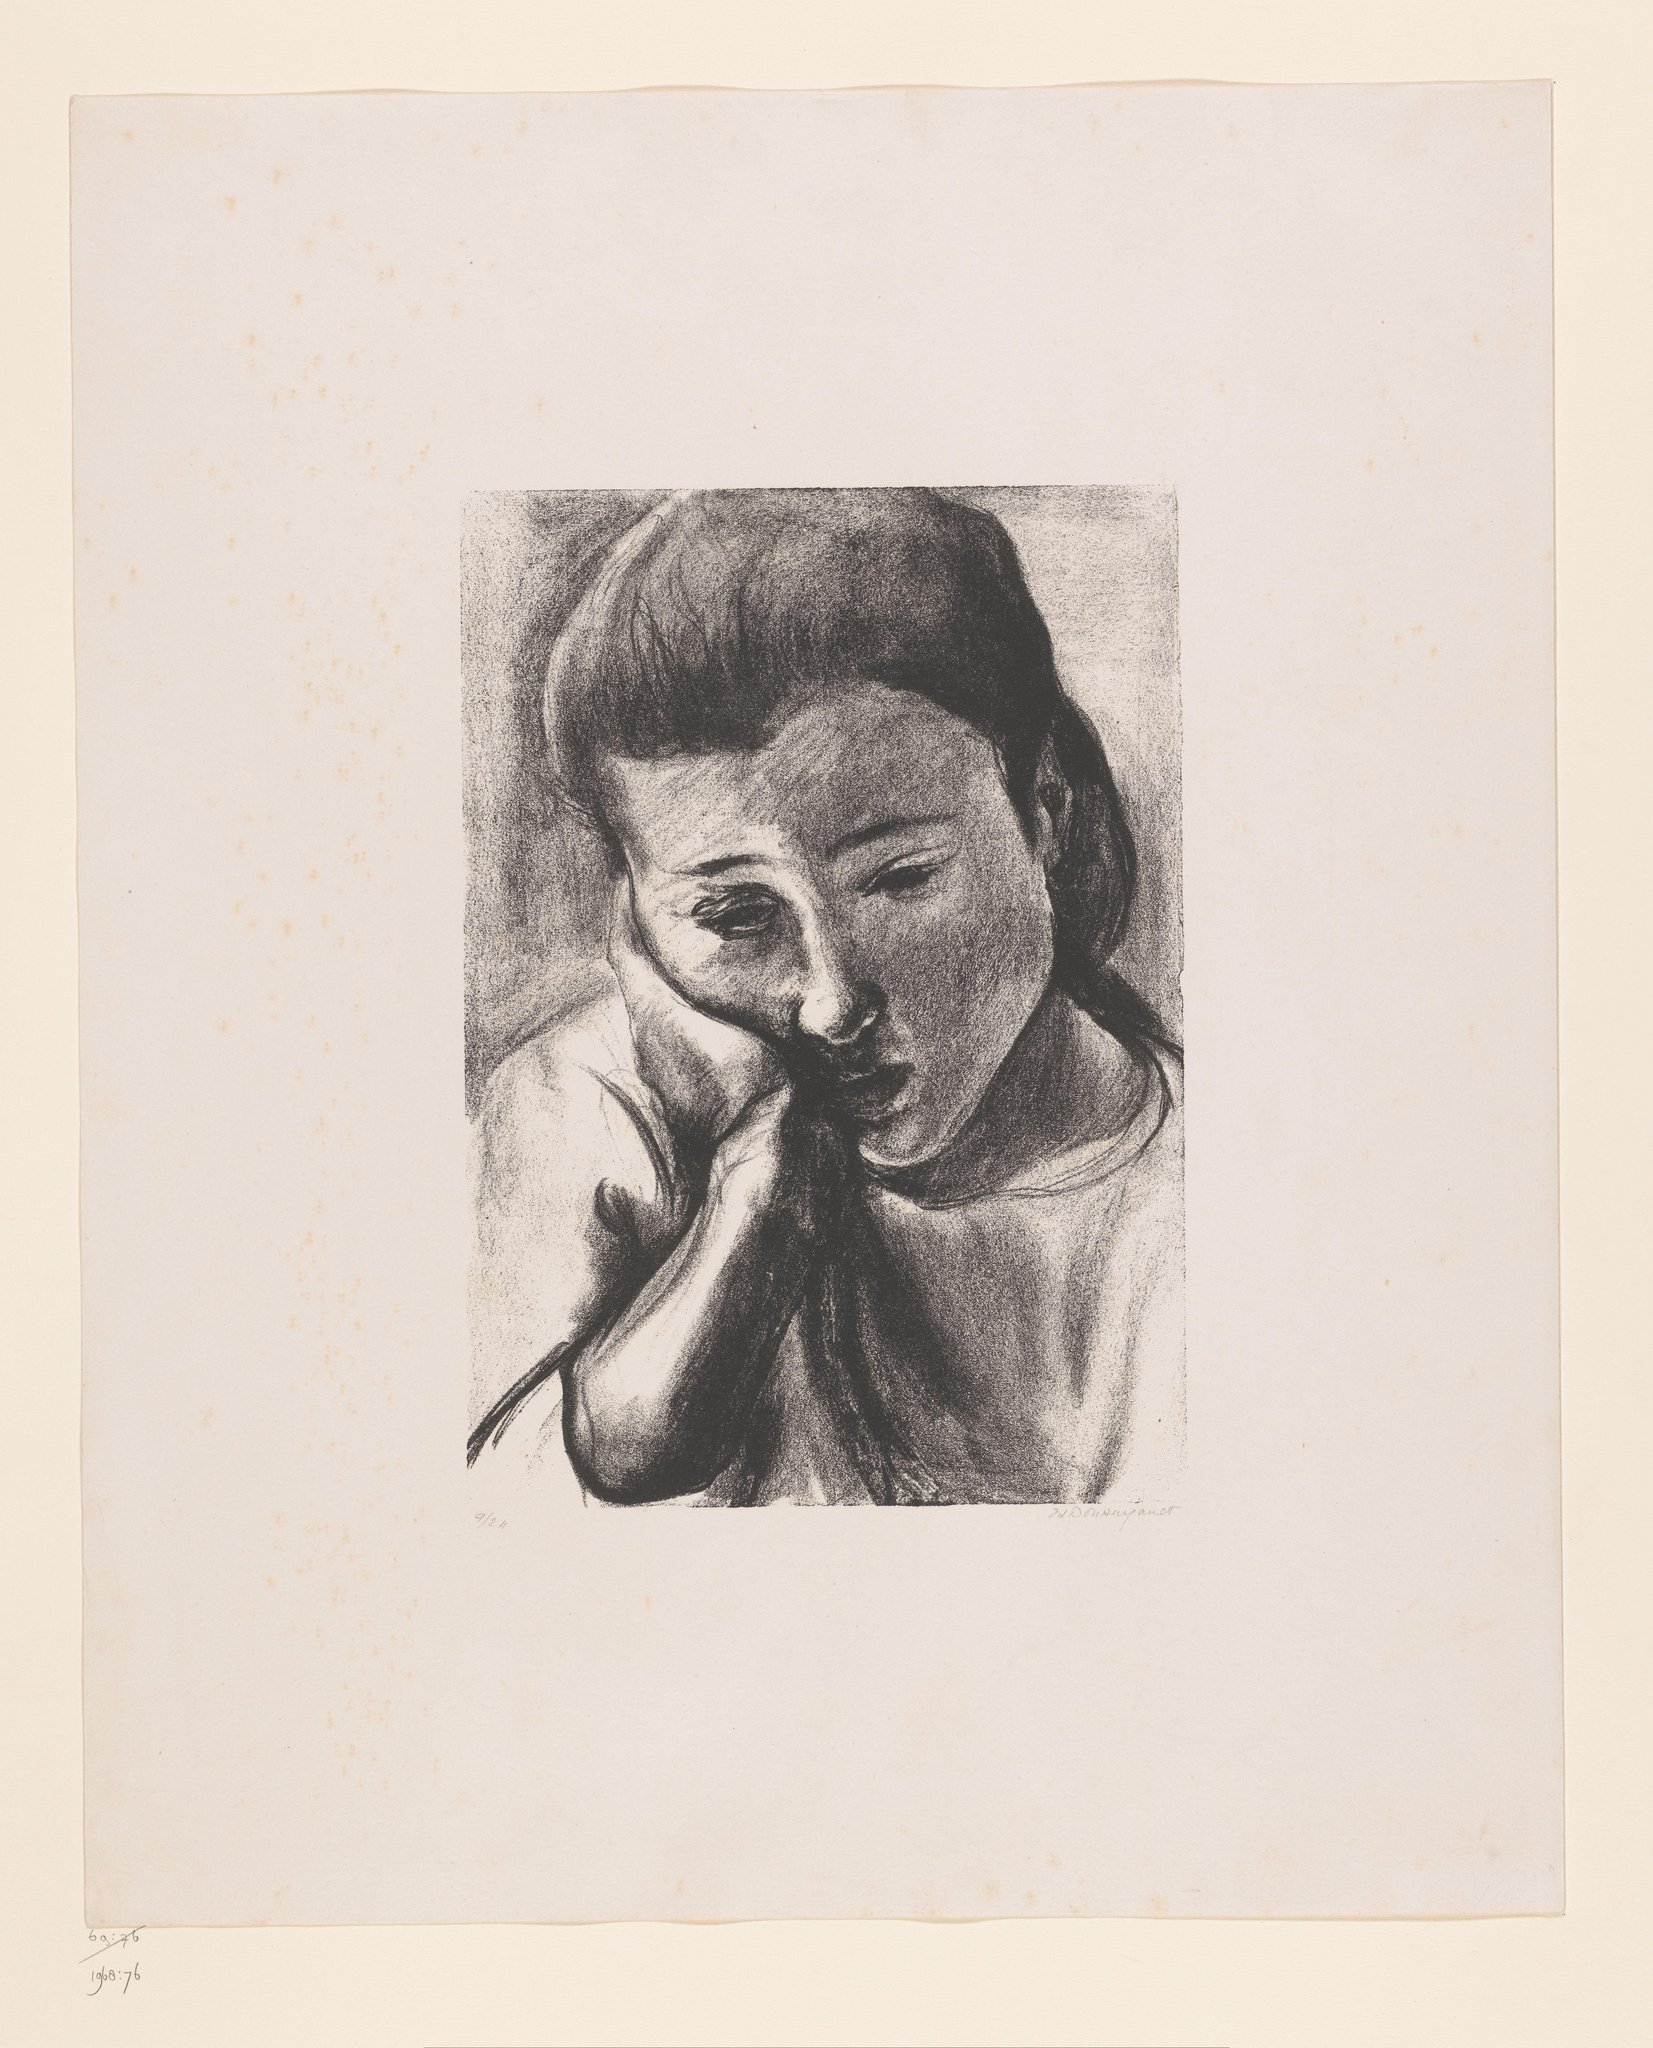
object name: print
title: Portret van een onbekende jonge vrouw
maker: jean-louis boussingault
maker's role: painter, print maker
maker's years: 1883-1943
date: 1893-1943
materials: paper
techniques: lithograph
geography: france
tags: adolescent, young woman, maiden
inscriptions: collector's mark: Lugt 2228, collector's mark: Lugt 2760